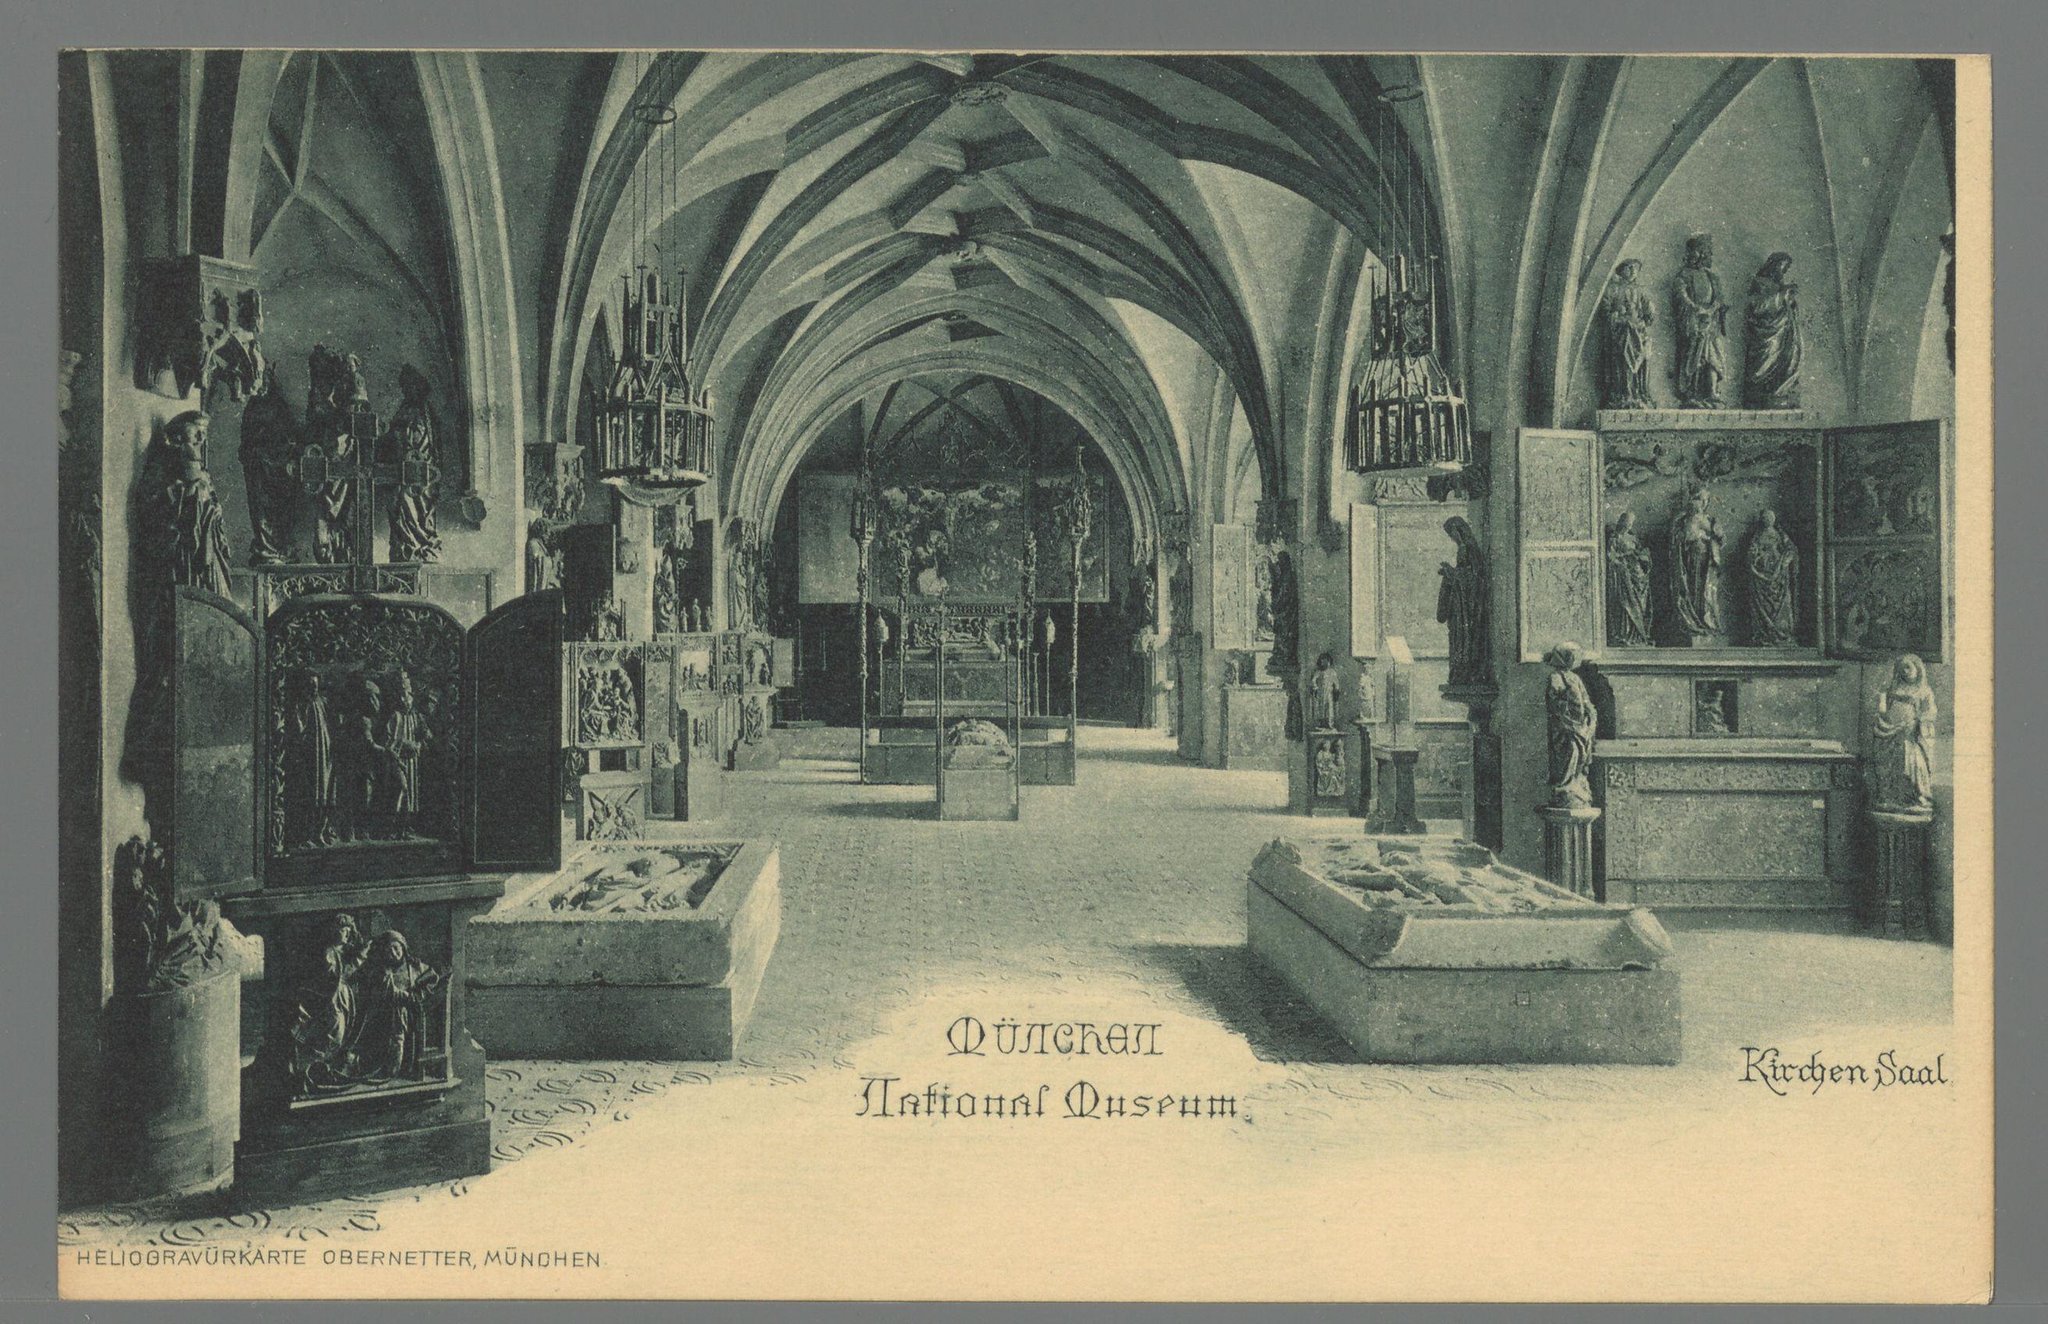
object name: photomechanical print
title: München. National Museum. Kirchen Saal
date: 1885-1905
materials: cardboard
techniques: photoaquatint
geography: munich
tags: permanent exhibition, museum